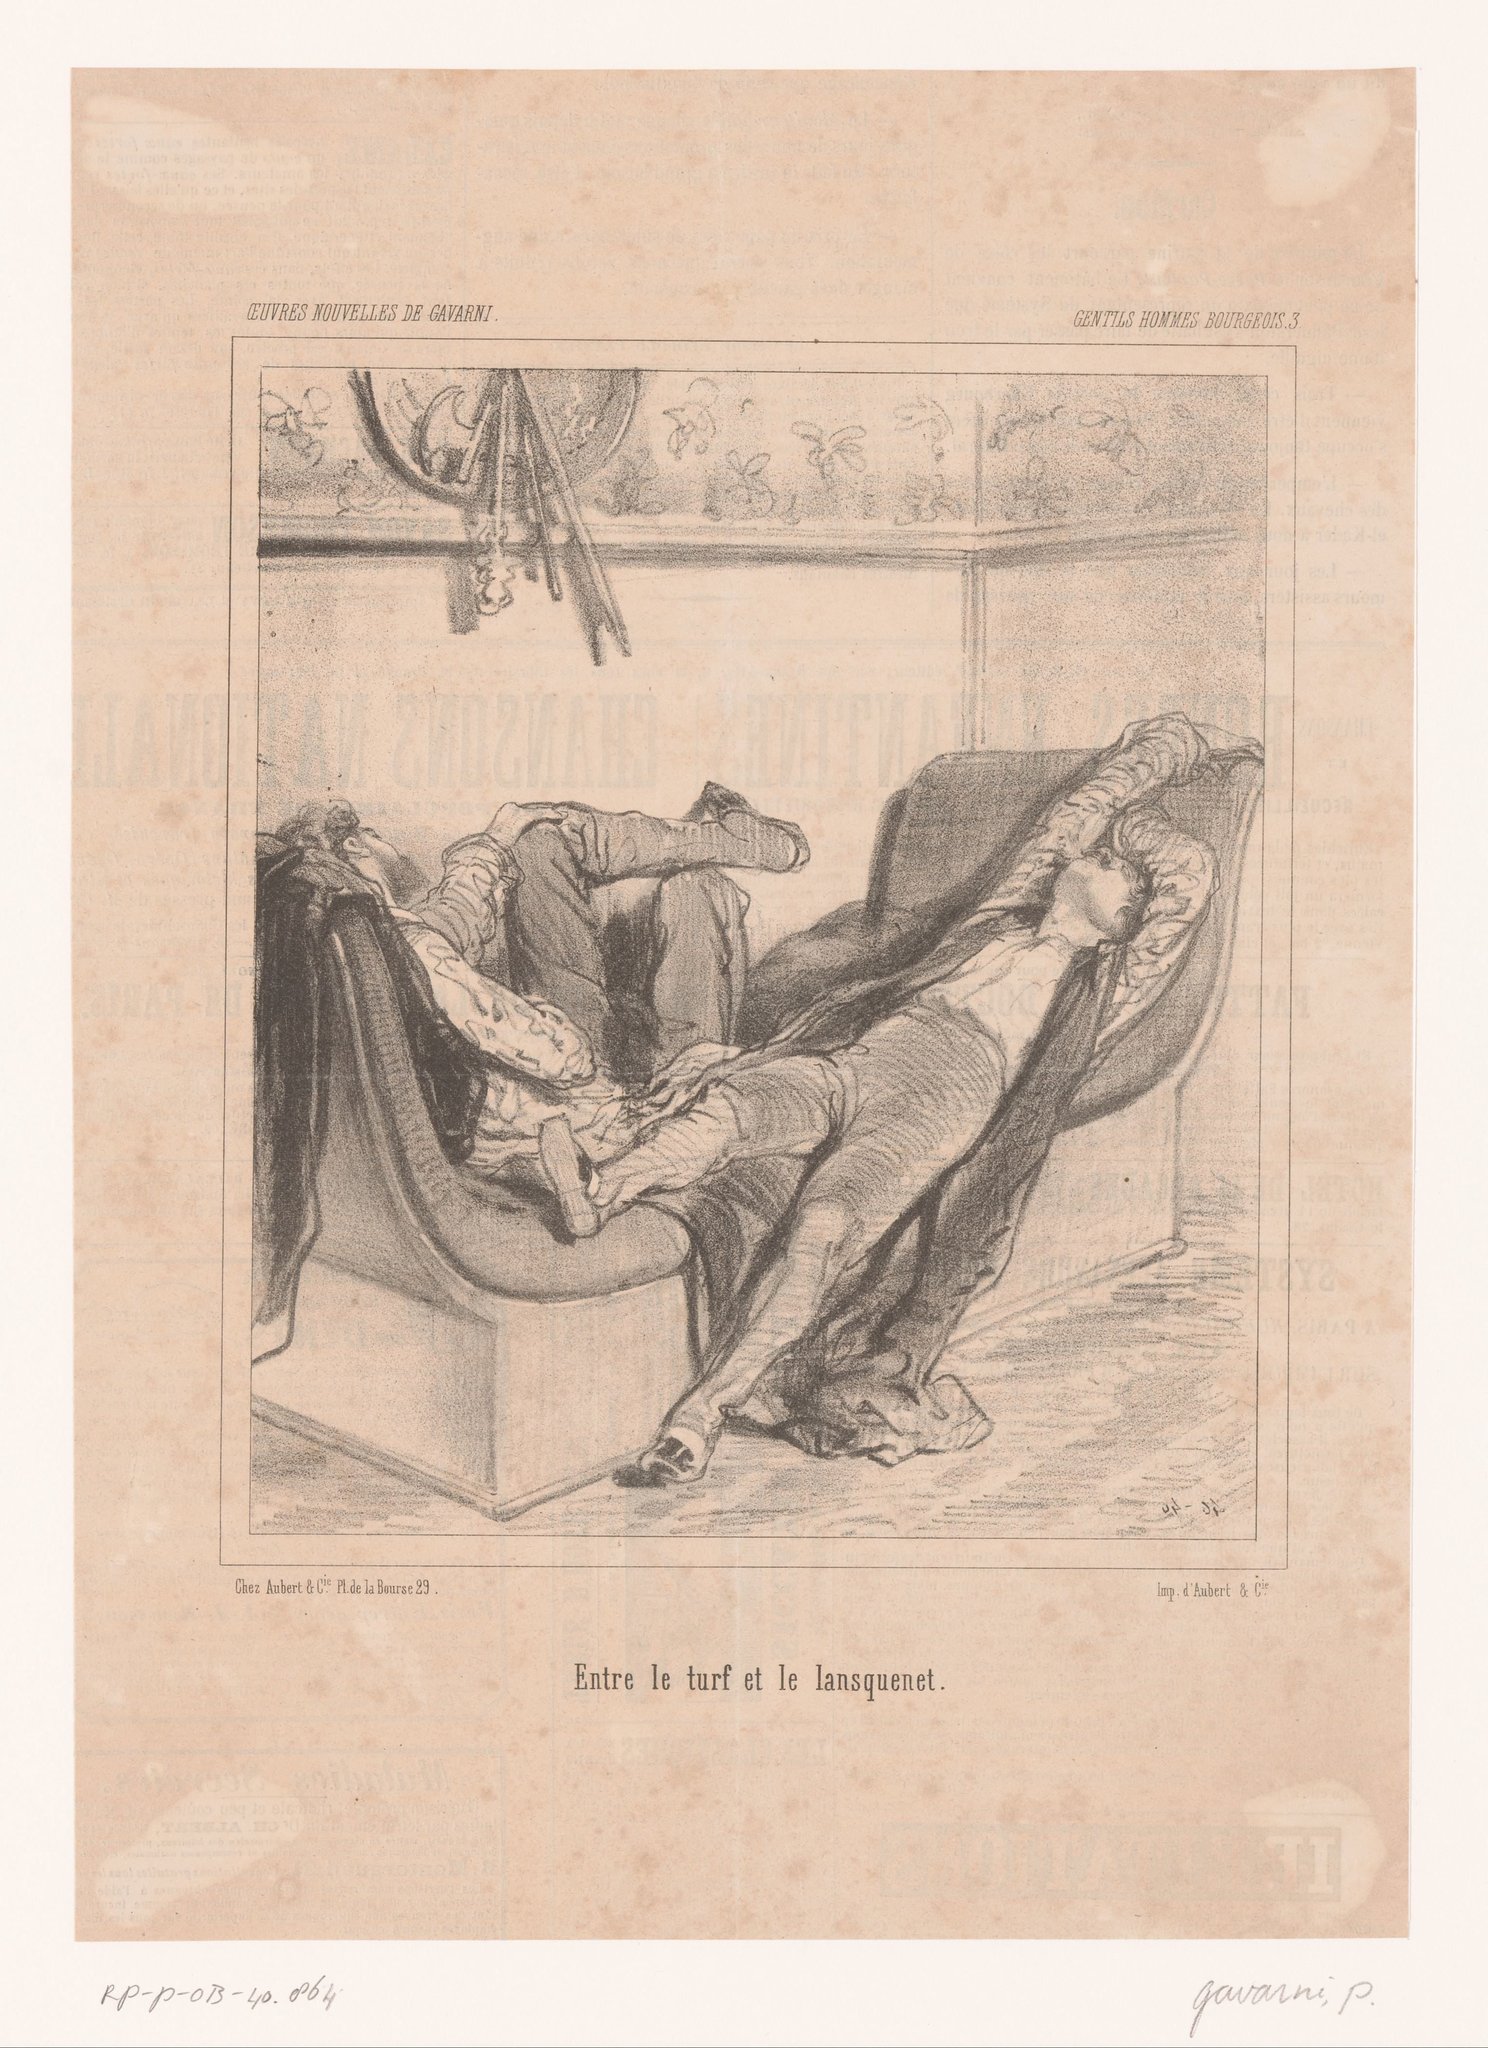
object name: cartoon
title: Twee gokkers slapend op een divan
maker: paul gavarni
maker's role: draughtsman, print maker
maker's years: 1804-1866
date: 1846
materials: paper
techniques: lithograph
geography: paris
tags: sleeping in chair, games of calculation and chance, e.g.: card games, gambling, puzzles, etc., couch, sofa, settee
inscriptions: collector's mark: Lugt 2228a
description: Prent gebruikt voor: Le Charivari, 3 oktober 1846. Entre le turf et le lansquenet: turf verwijst naar de paardenraces, terwijl lansquenet verwijst naar een kaartspel dat in Frankrijk werd geïntroduceerd door de landsknechten. Dit spel won aan populariteit onder Franse burgers tot ca. 1870.